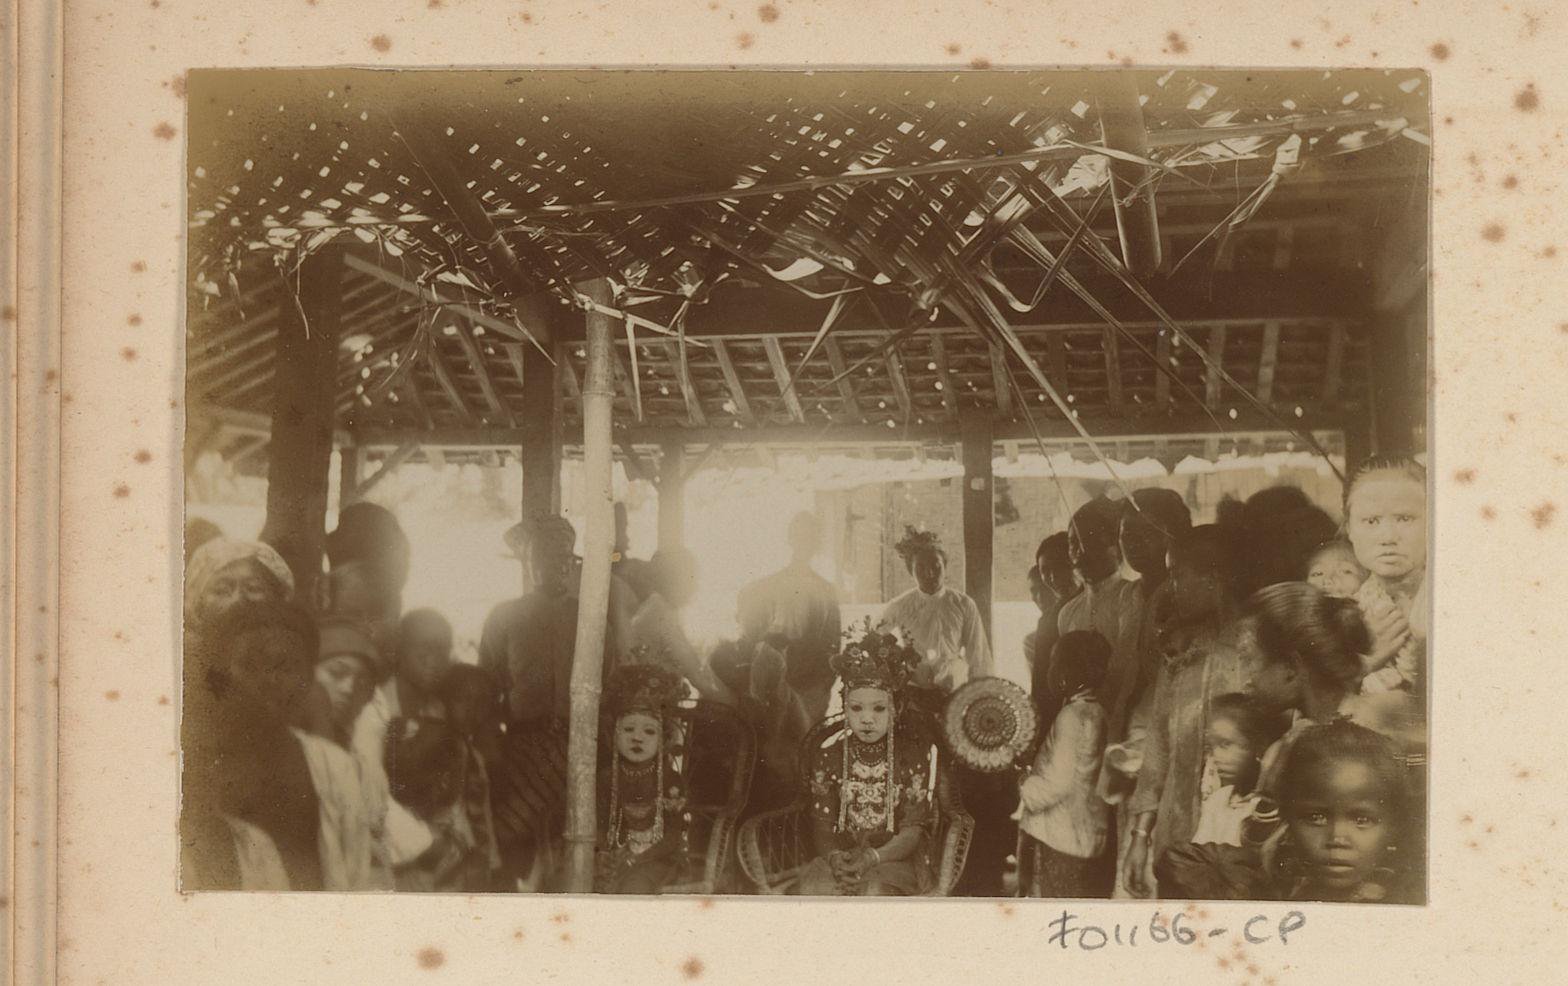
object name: album leaf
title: Nederlands-Indië, verklede kinderen bij feest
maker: Anonymous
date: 1880-1910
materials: photographic support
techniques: gelatin silver print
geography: dutch east indies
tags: child, historical persons, folk costume, regional costume, dutch east indies, the